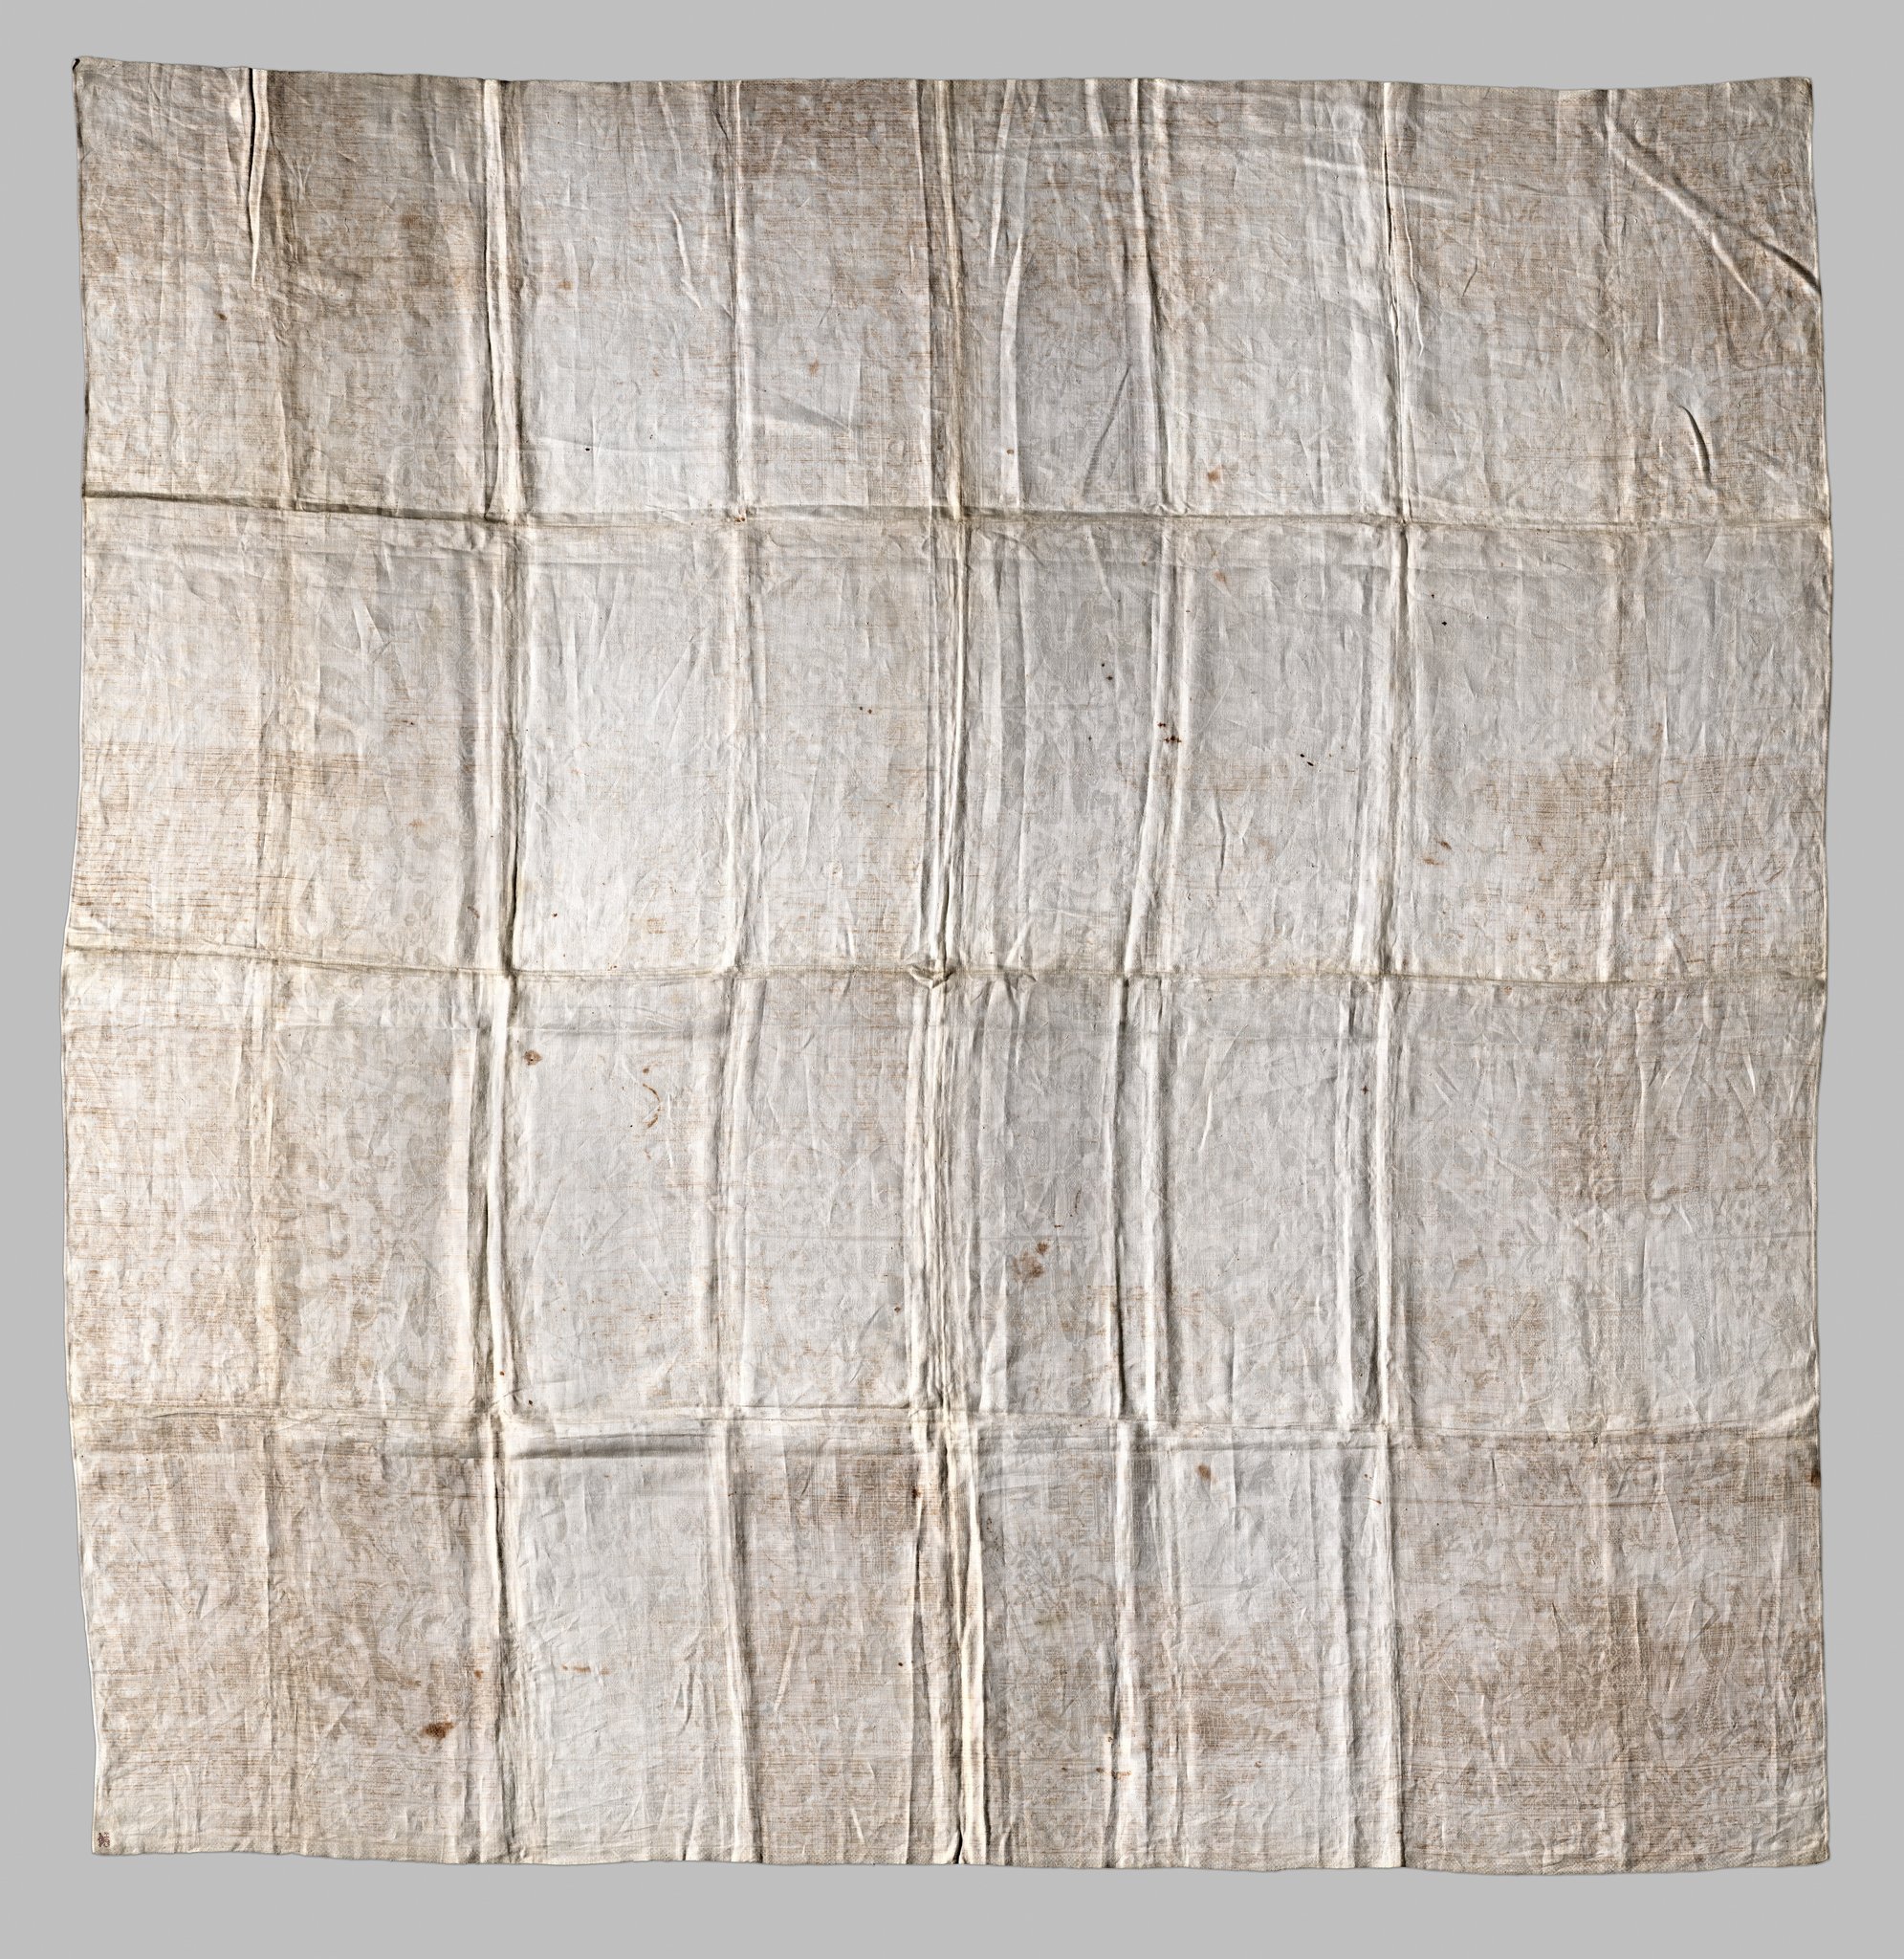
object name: tablecloth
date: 1601-1700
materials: linen